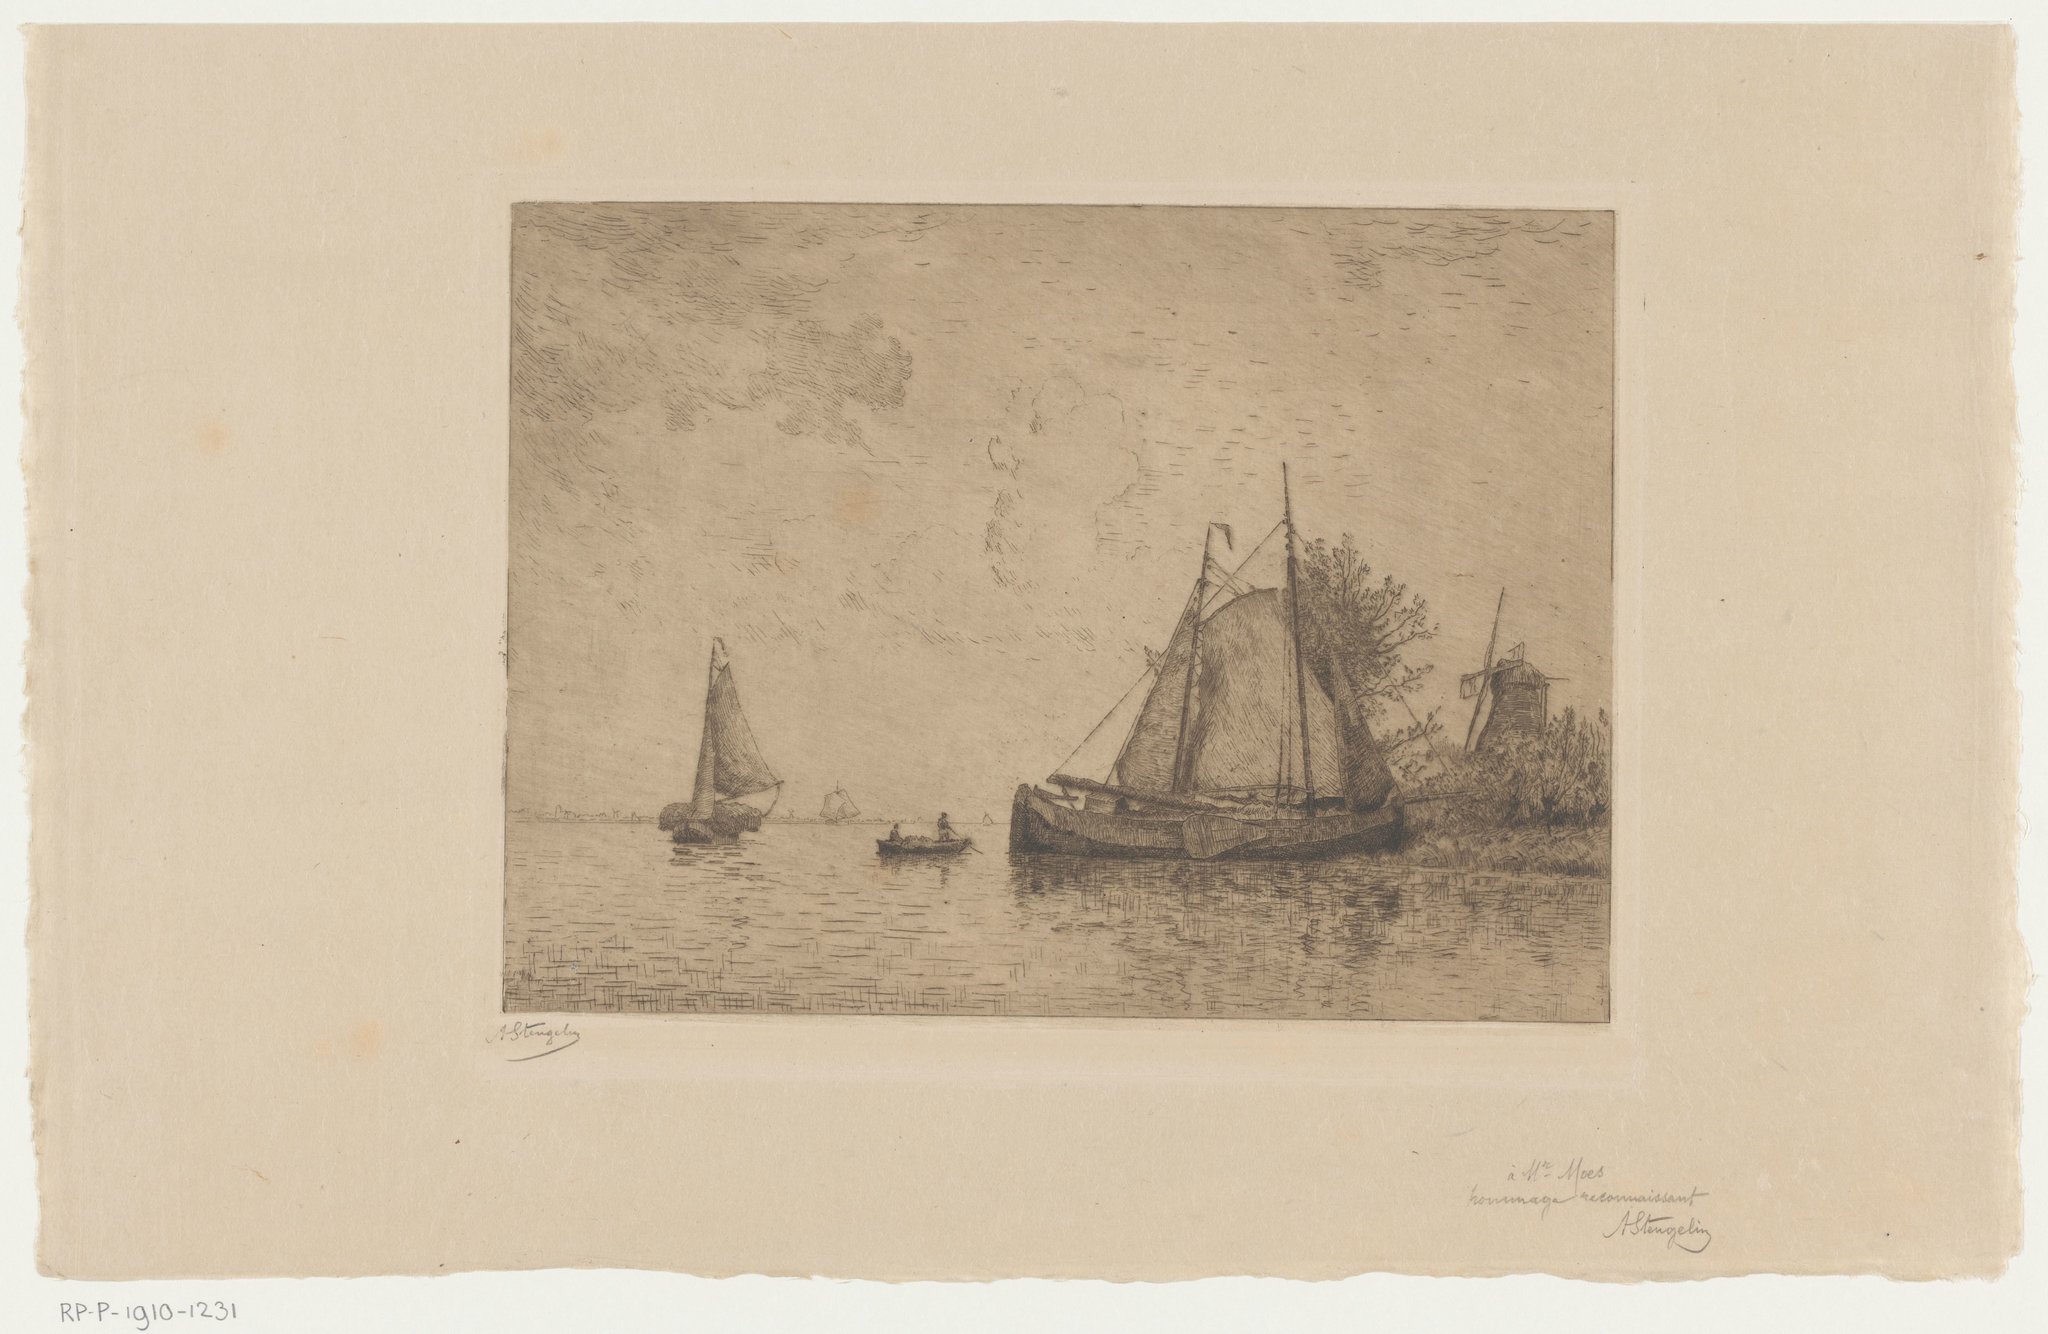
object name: print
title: Gezicht op de Maas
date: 1862-1910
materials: paper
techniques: etching, intaglio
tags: sailing-ship, sailing-boat, river, windmill in landscape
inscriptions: collector's mark: Lugt 2228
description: Gezicht op de Maas met op de voorgrond twee zeilboten en een roeiboot. Rechts een molen.